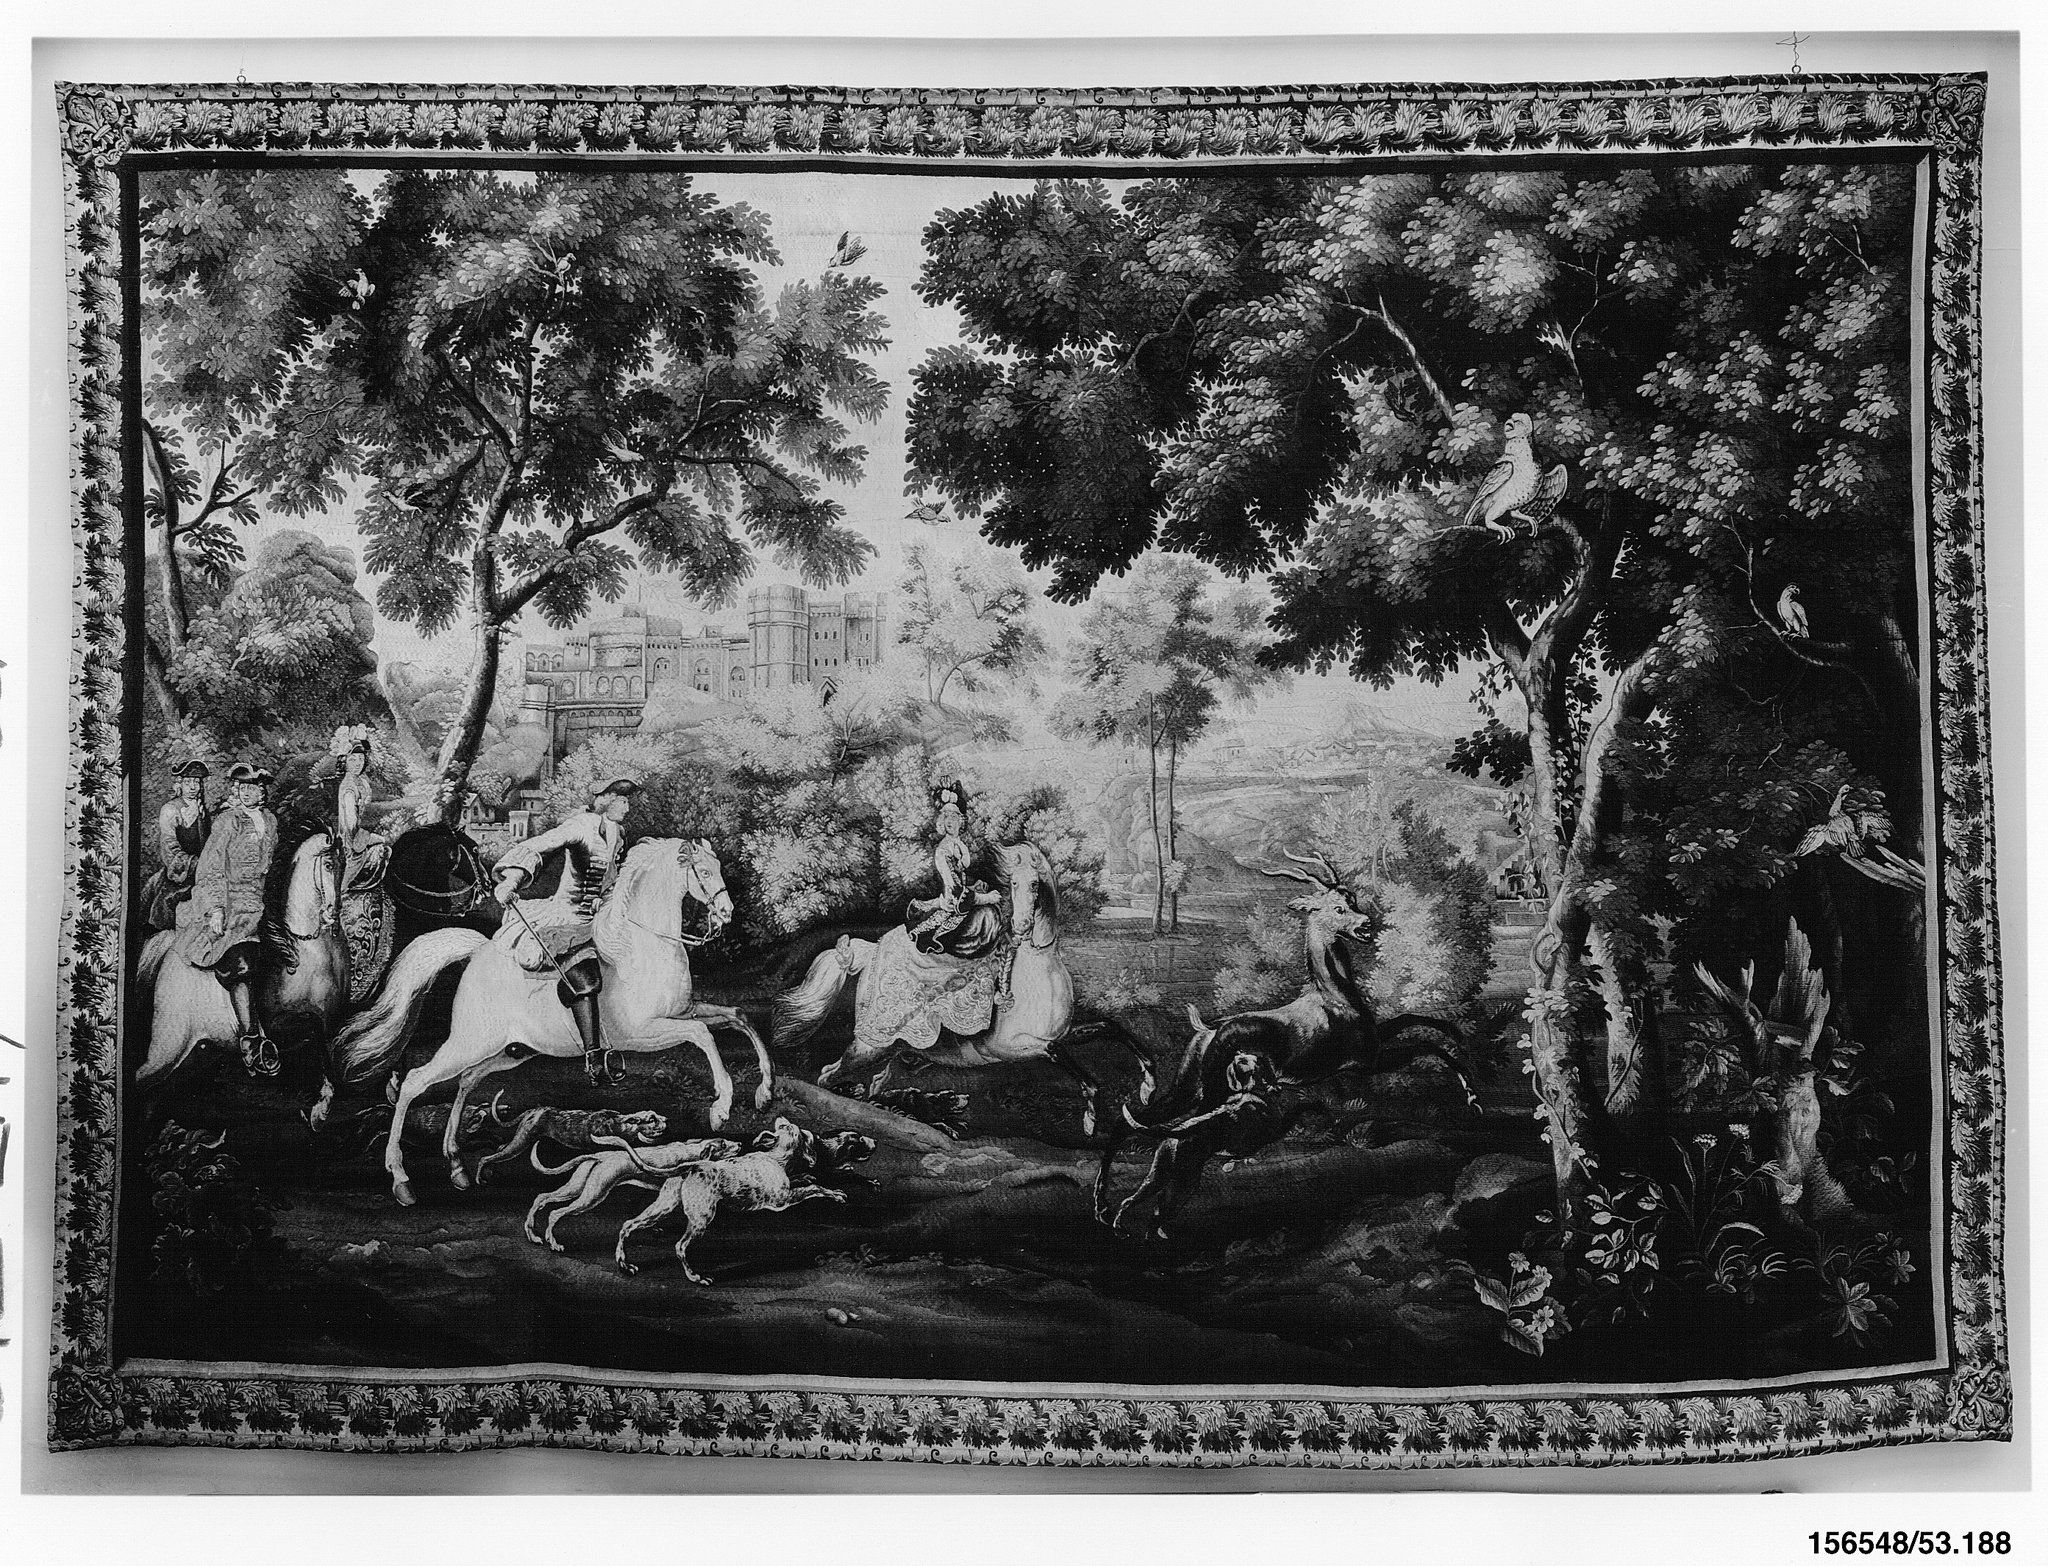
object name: tapestry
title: Stag Hunt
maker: beauvais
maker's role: manufactory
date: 1667-1700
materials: silk, wool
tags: men,hunting,deer,horses,trees